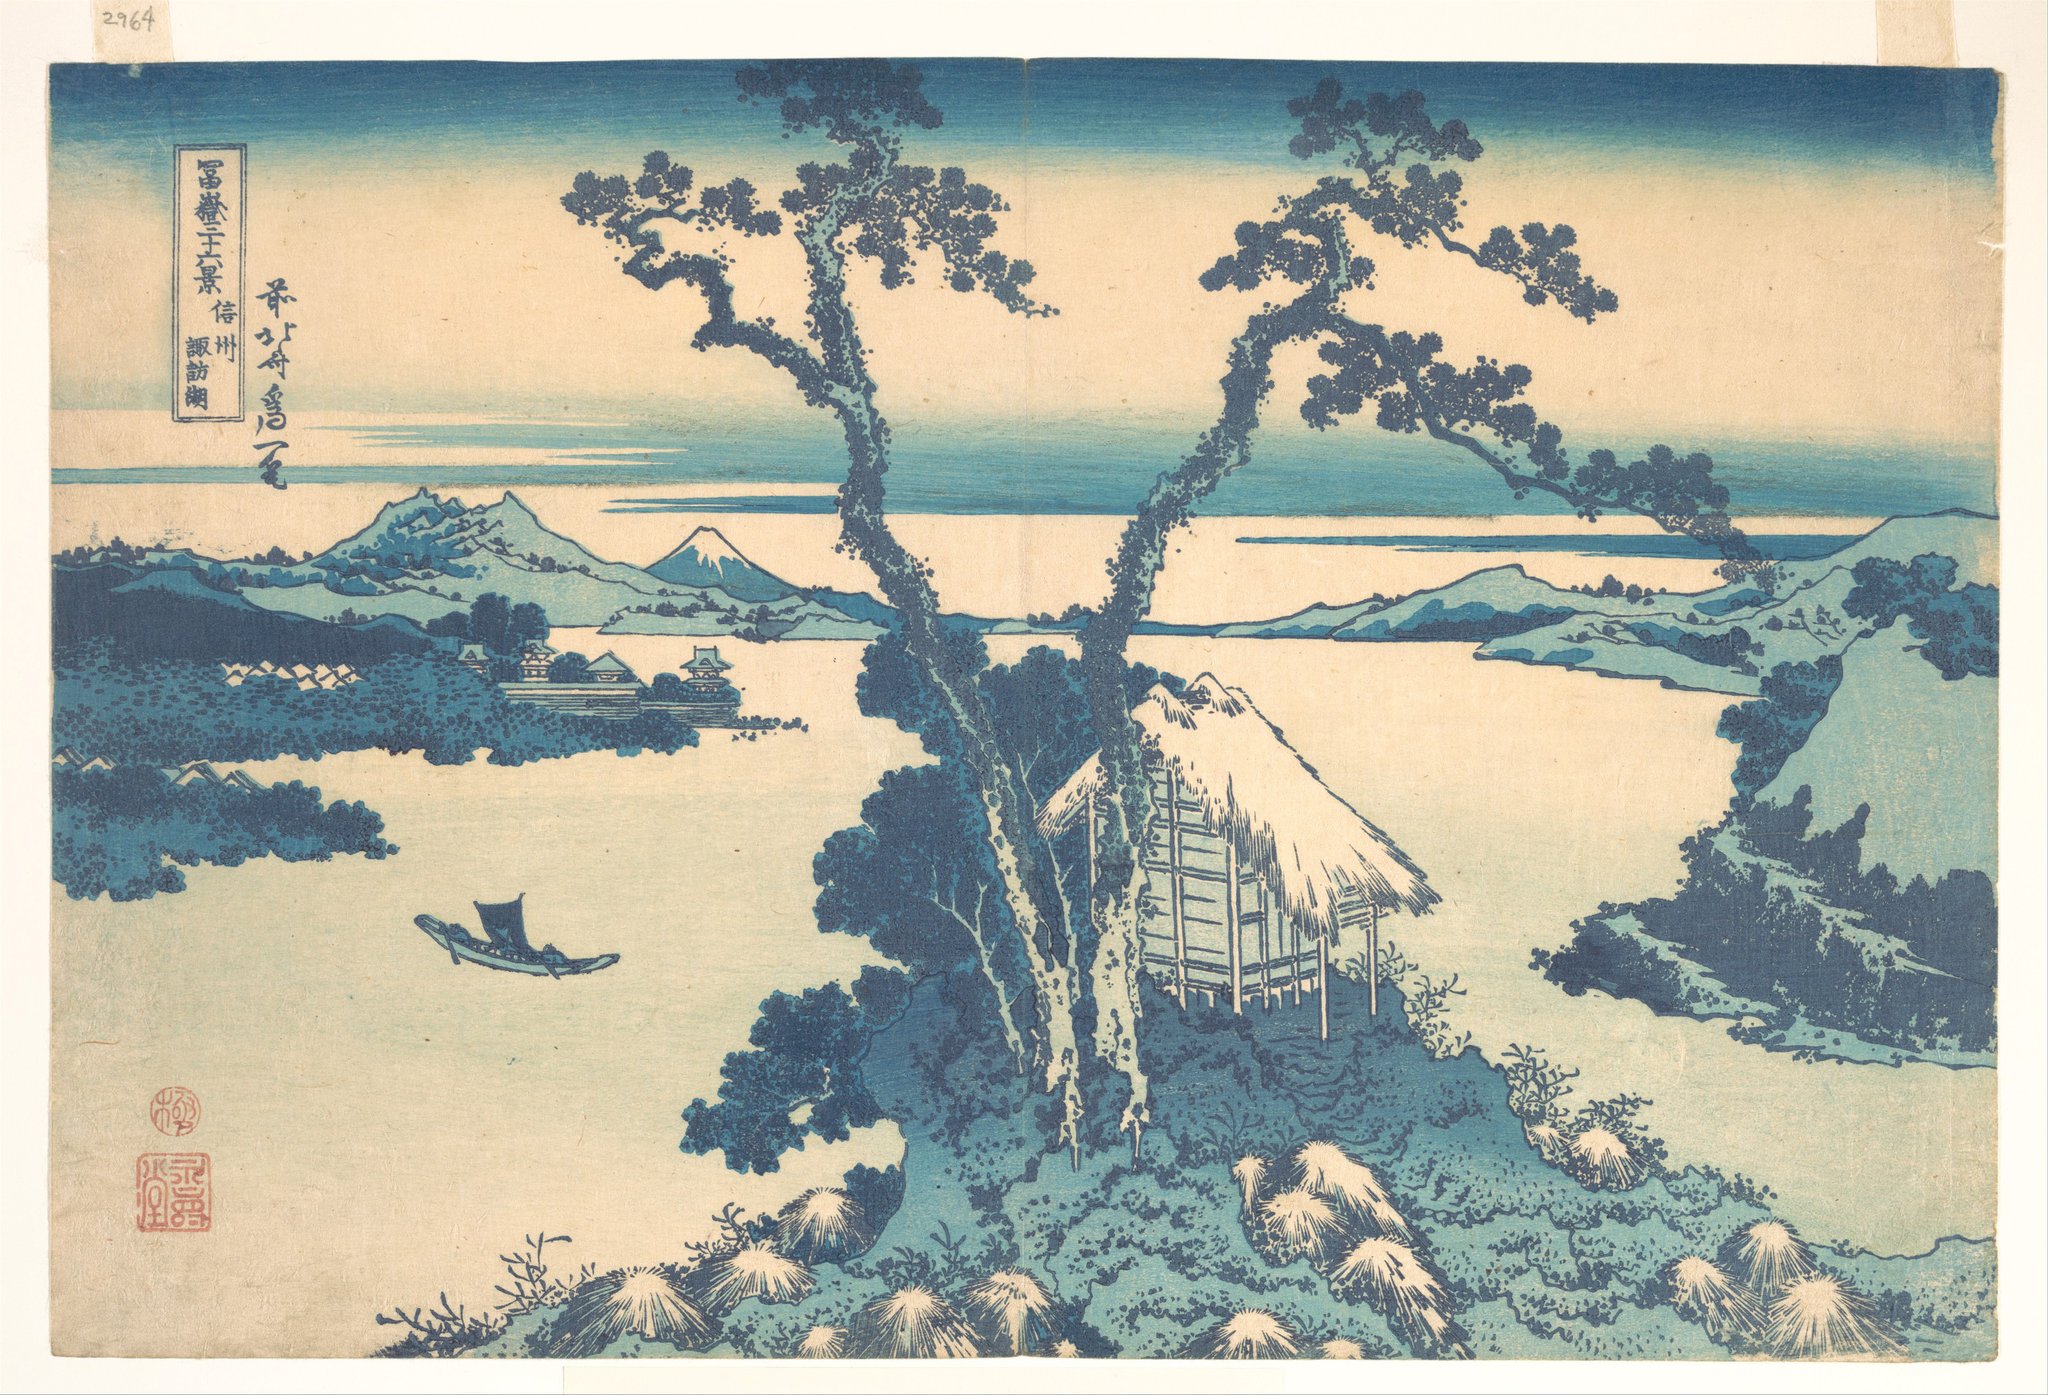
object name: woodblock print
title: Lake Suwa in Shinano Province (Shinshū Suwako), from the series Thirty-six Views of Mount Fuji (Fugaku sanjūrokkei)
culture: japanese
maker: katsushika hokusai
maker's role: artist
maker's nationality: japanese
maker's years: 1760-1849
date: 1830-1832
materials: ink, paper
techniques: woodblock print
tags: houses,lakes,volcanoes,trees,boats